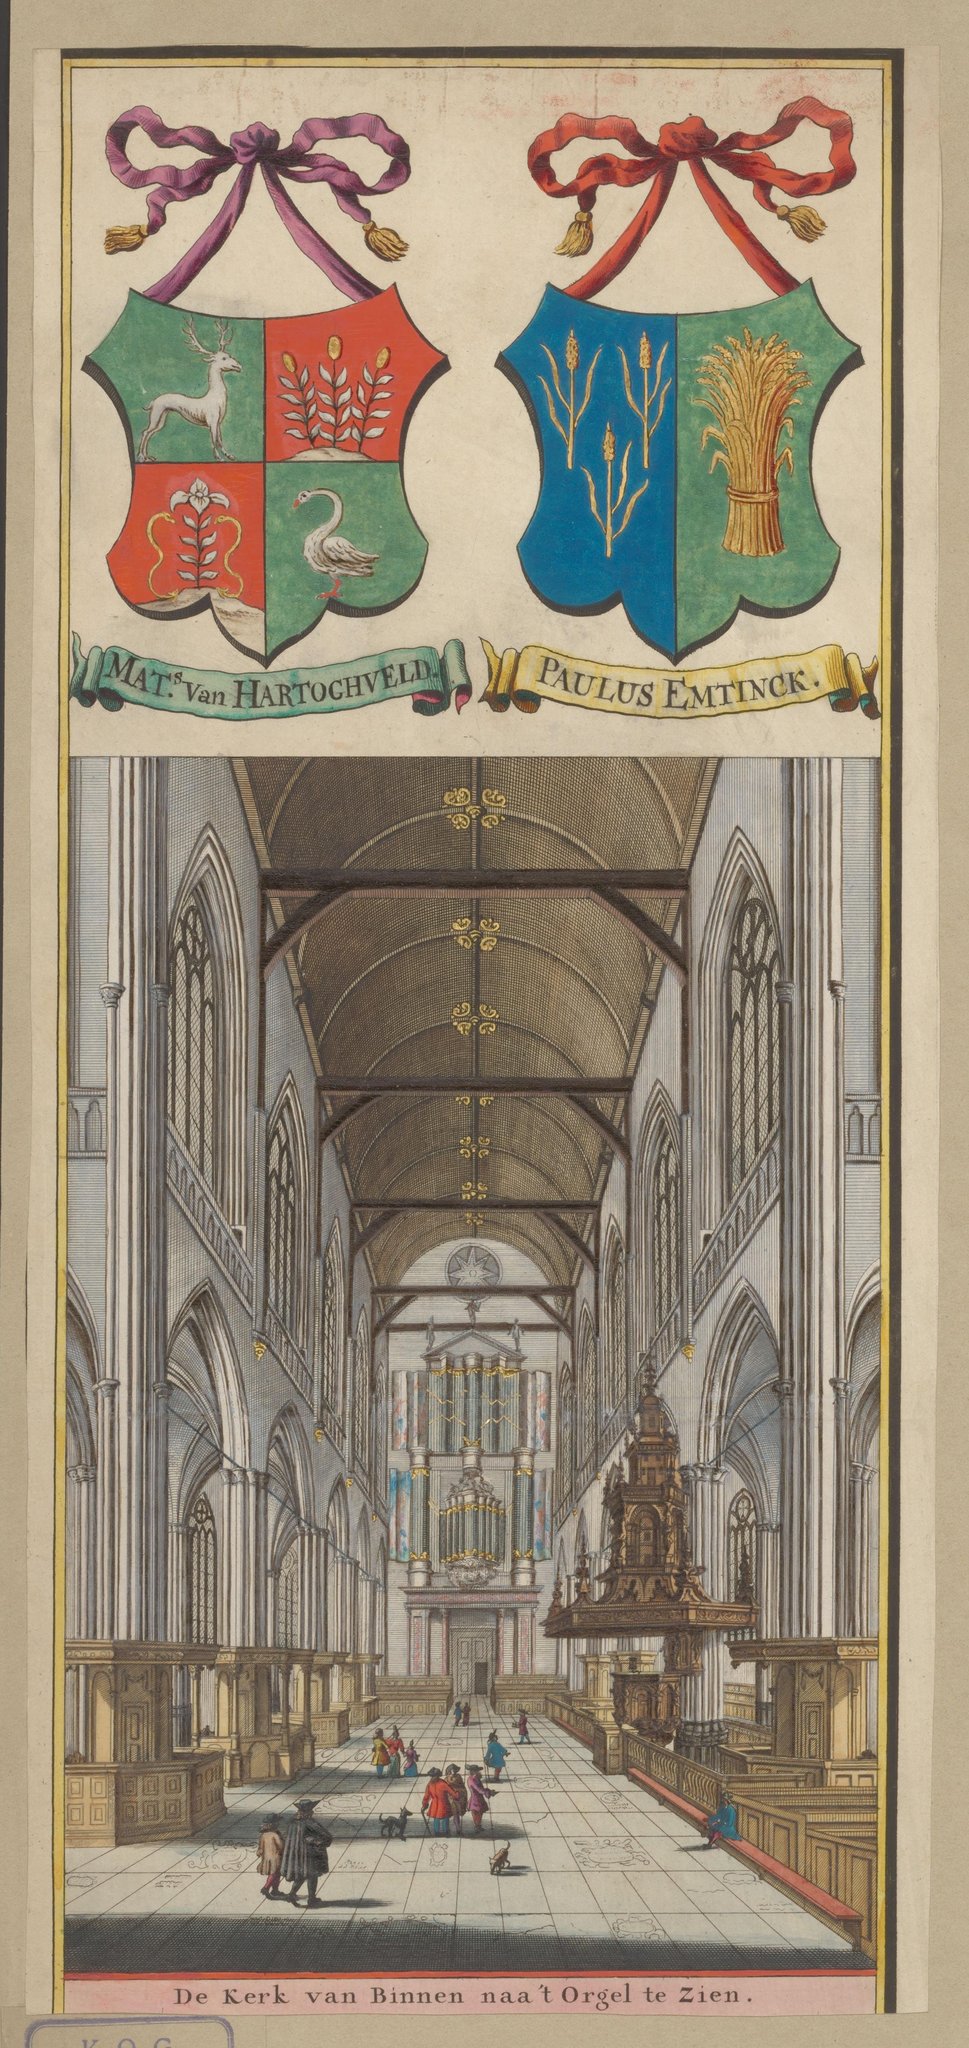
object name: print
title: De Kerk van Binnen naa 't Orgel te Zien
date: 1719-1721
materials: gouache, ink, paper, watercolor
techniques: engraving, etching, hand coloring, pen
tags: church organ, interior of church, armorial bearing, heraldry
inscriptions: collector's mark: Lugt 1641b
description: Niet-gemonteerde randprent van 'Afbeeldinge vande Sitplaatsen inde Nieuwe-Kerk', een plattegrond van de zitplaatsen in de Nieuwe Kerk te Amsterdam, met de wapens van kerkmeesters Matthias van Hartoghveld en Paulus Emtinck. Uit een grotere prent met twee andere schilden en voorstellingen van het grafmonument van Michiel de Ruyter, het koor en het exterieur van dezelfde kerk. Onderwerpsrubriek binnen de Atlas Amsterdam: Kerkwezen: Hervormde Gemeente: Nieuwe Kerk van buiten.